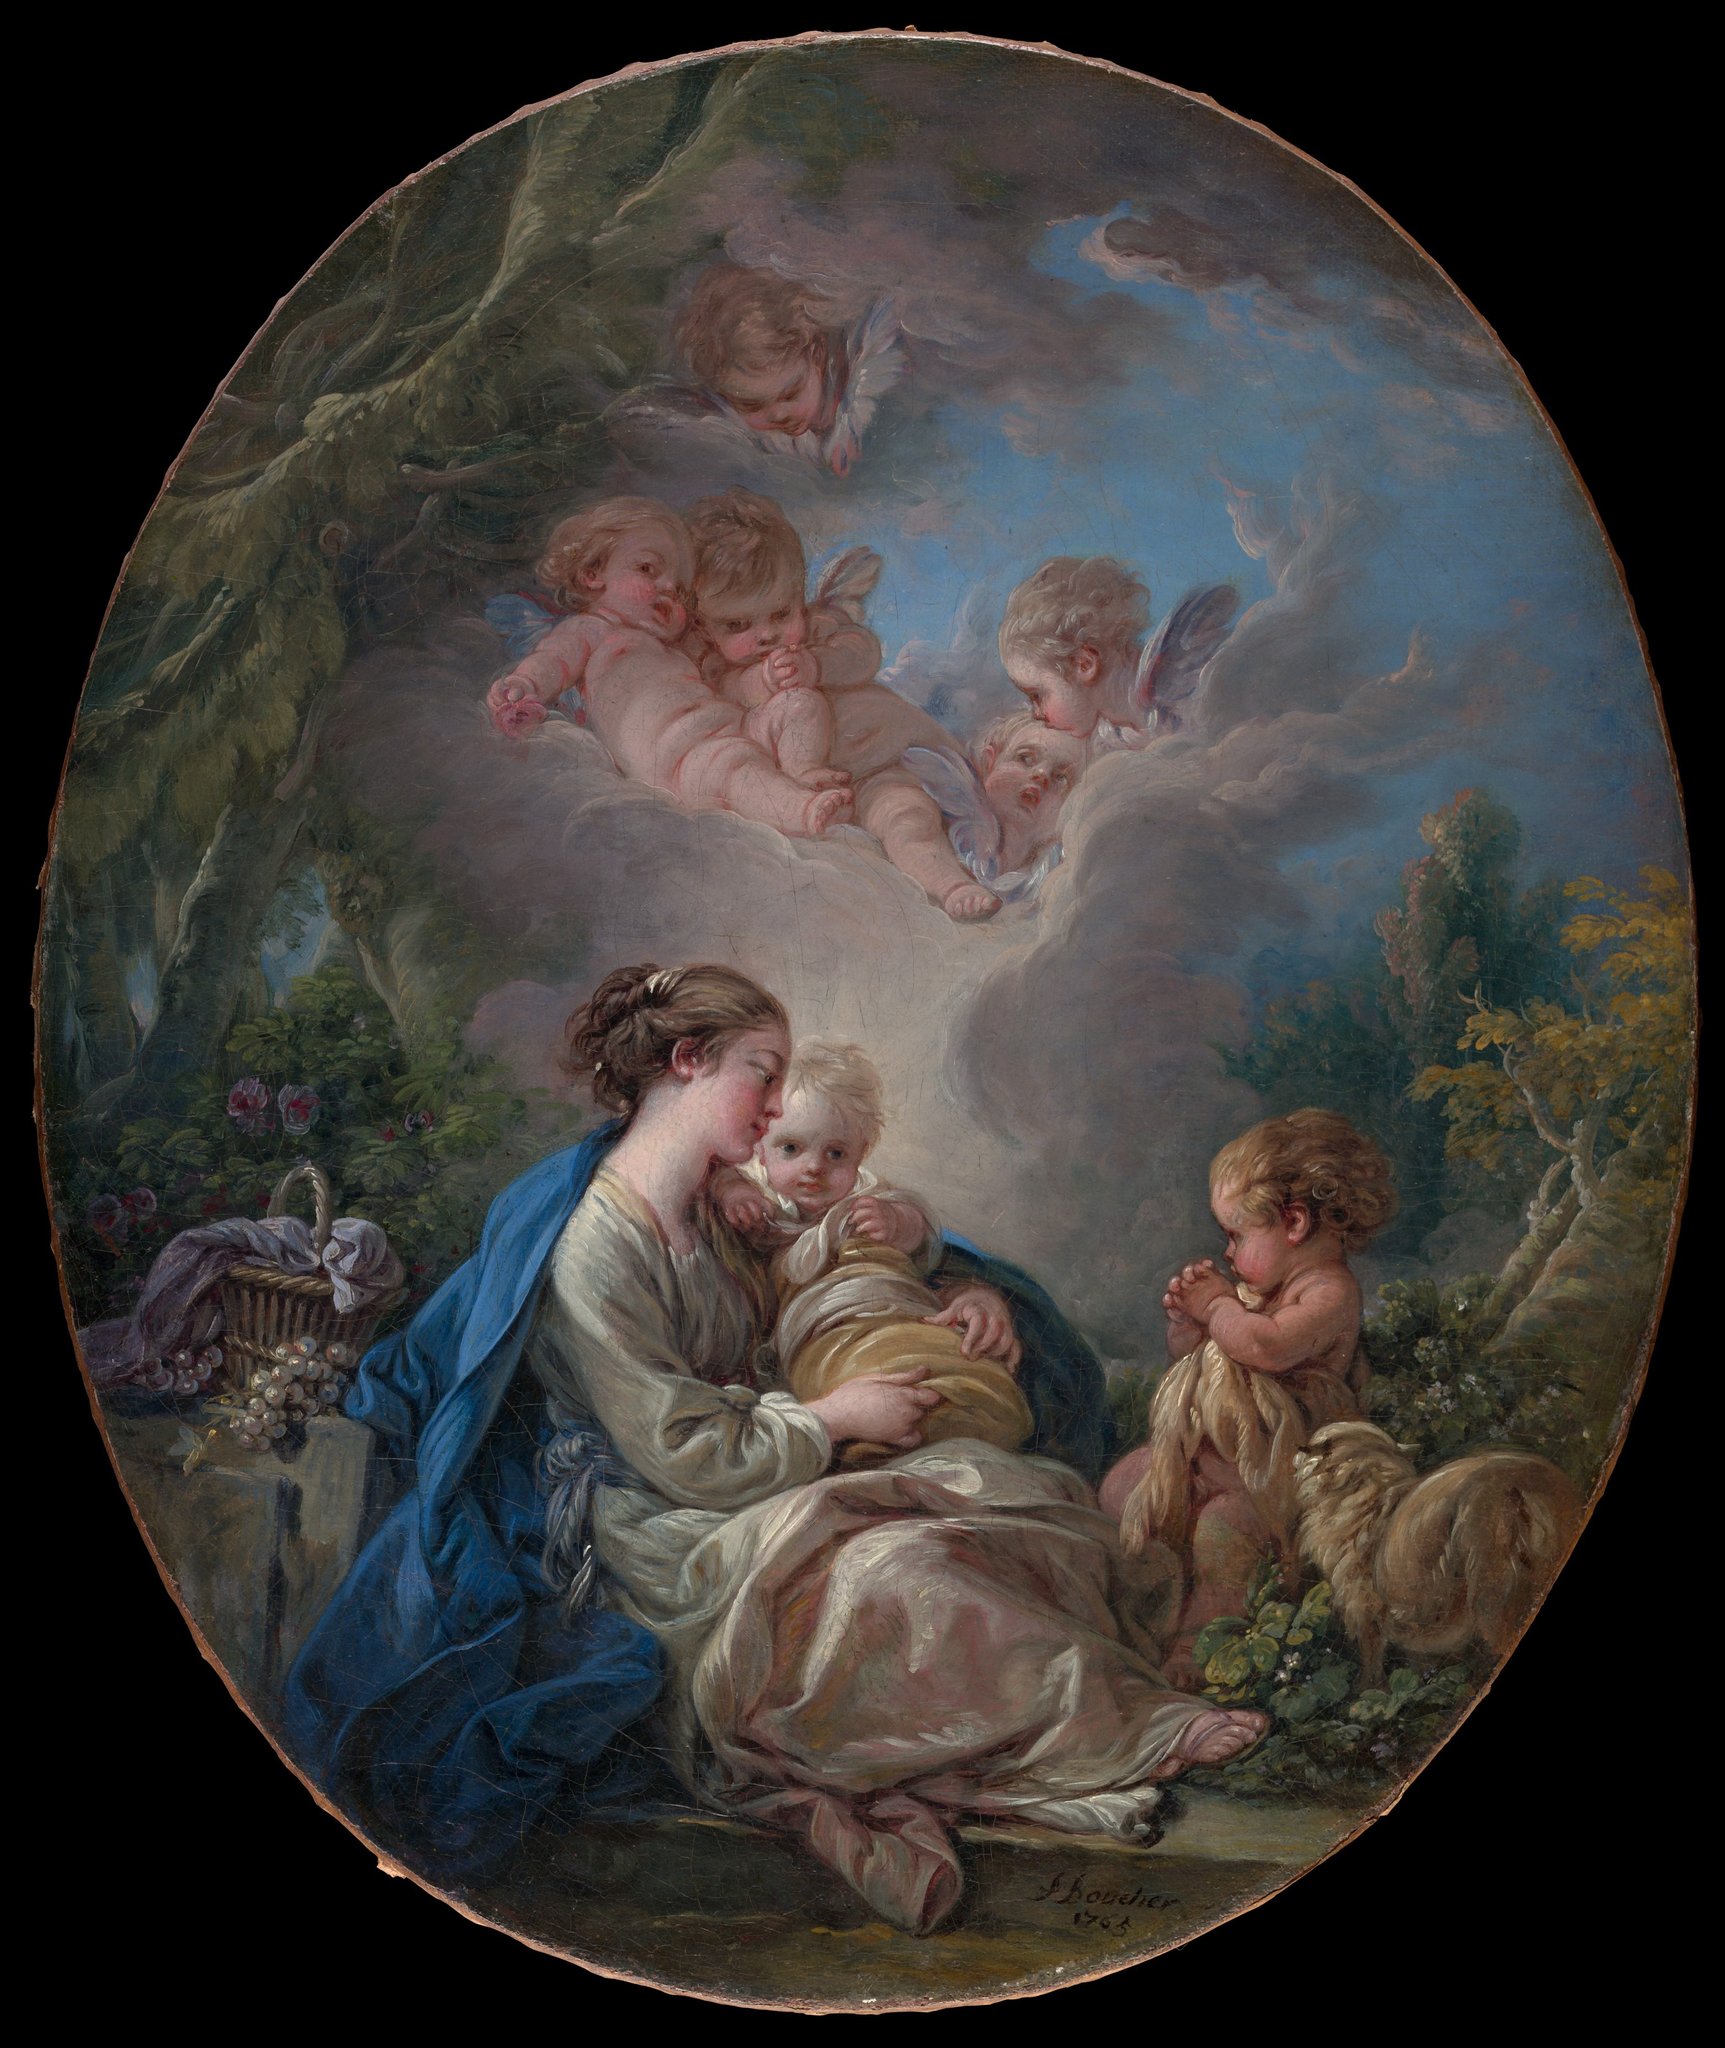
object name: painting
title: Virgin and Child with the Young Saint John the Baptist and Angels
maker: françois boucher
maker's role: artist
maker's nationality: french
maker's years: 1703-1770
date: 1765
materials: canvas, oil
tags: angels,madonna and child,saint john the baptist